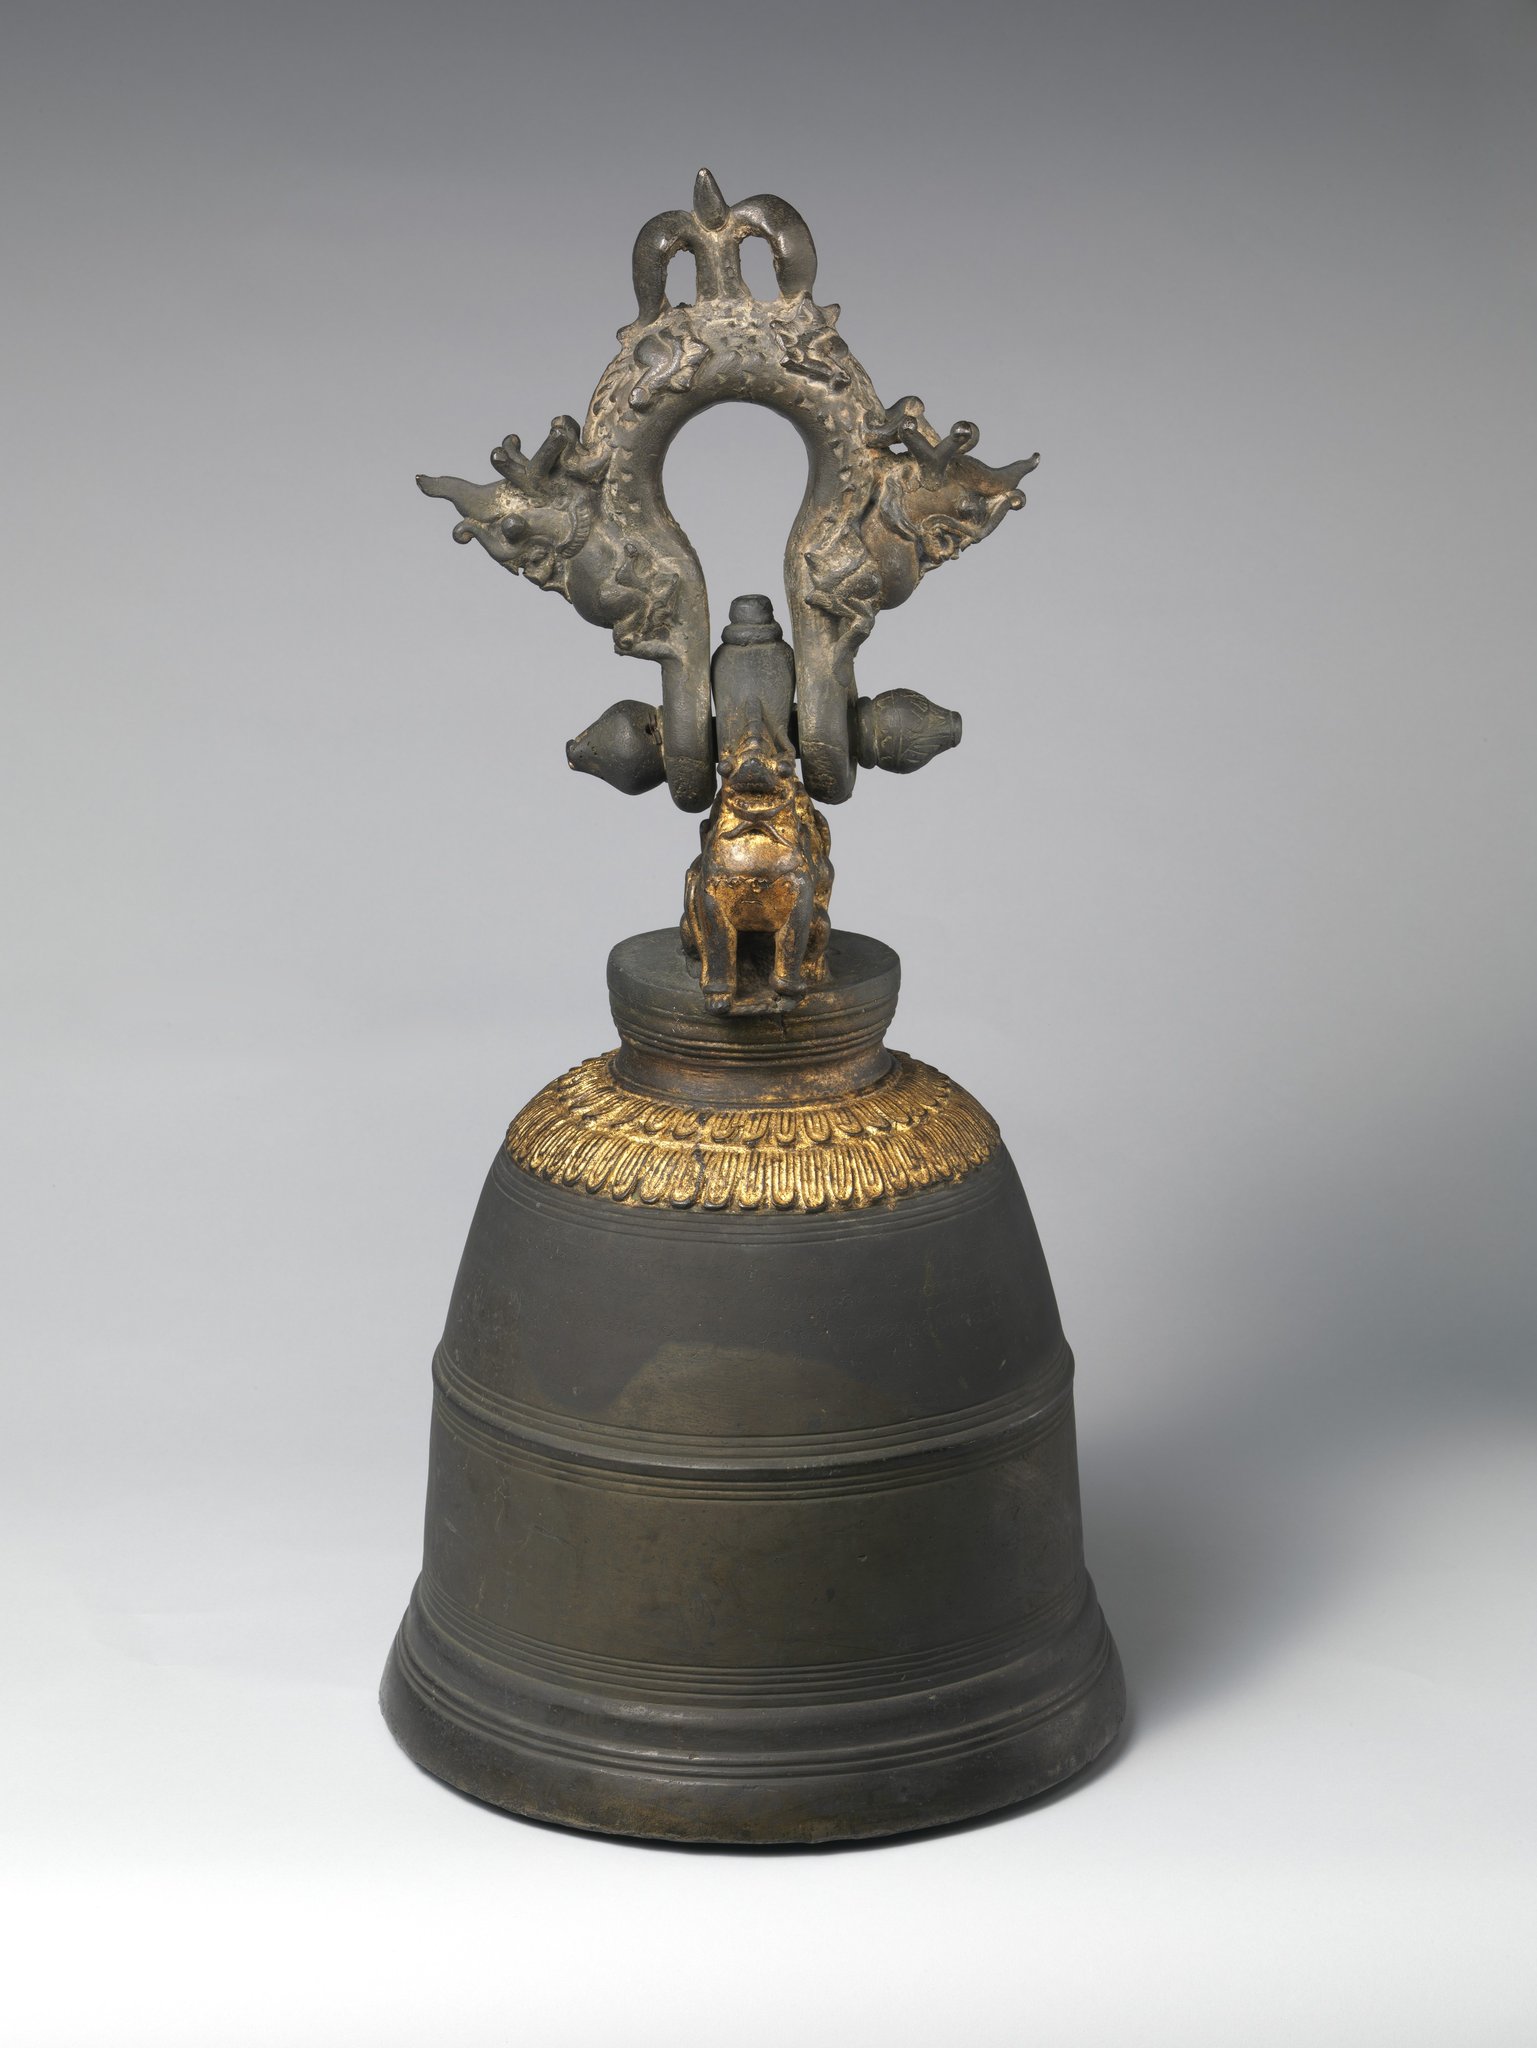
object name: bell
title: Monastery Bell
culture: burmese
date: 1879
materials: bronze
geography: myanmar